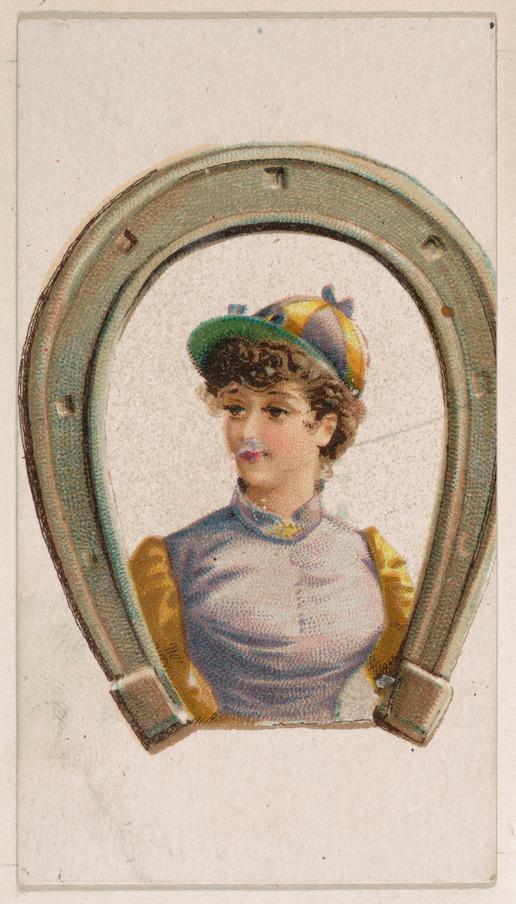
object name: print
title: Horseshoe, from the Novelties series (N228, Type 5) issued by Kinney Bros.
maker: kinney brothers tobacco company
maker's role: publisher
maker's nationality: american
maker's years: 1869-2011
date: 1889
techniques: color lithograph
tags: women